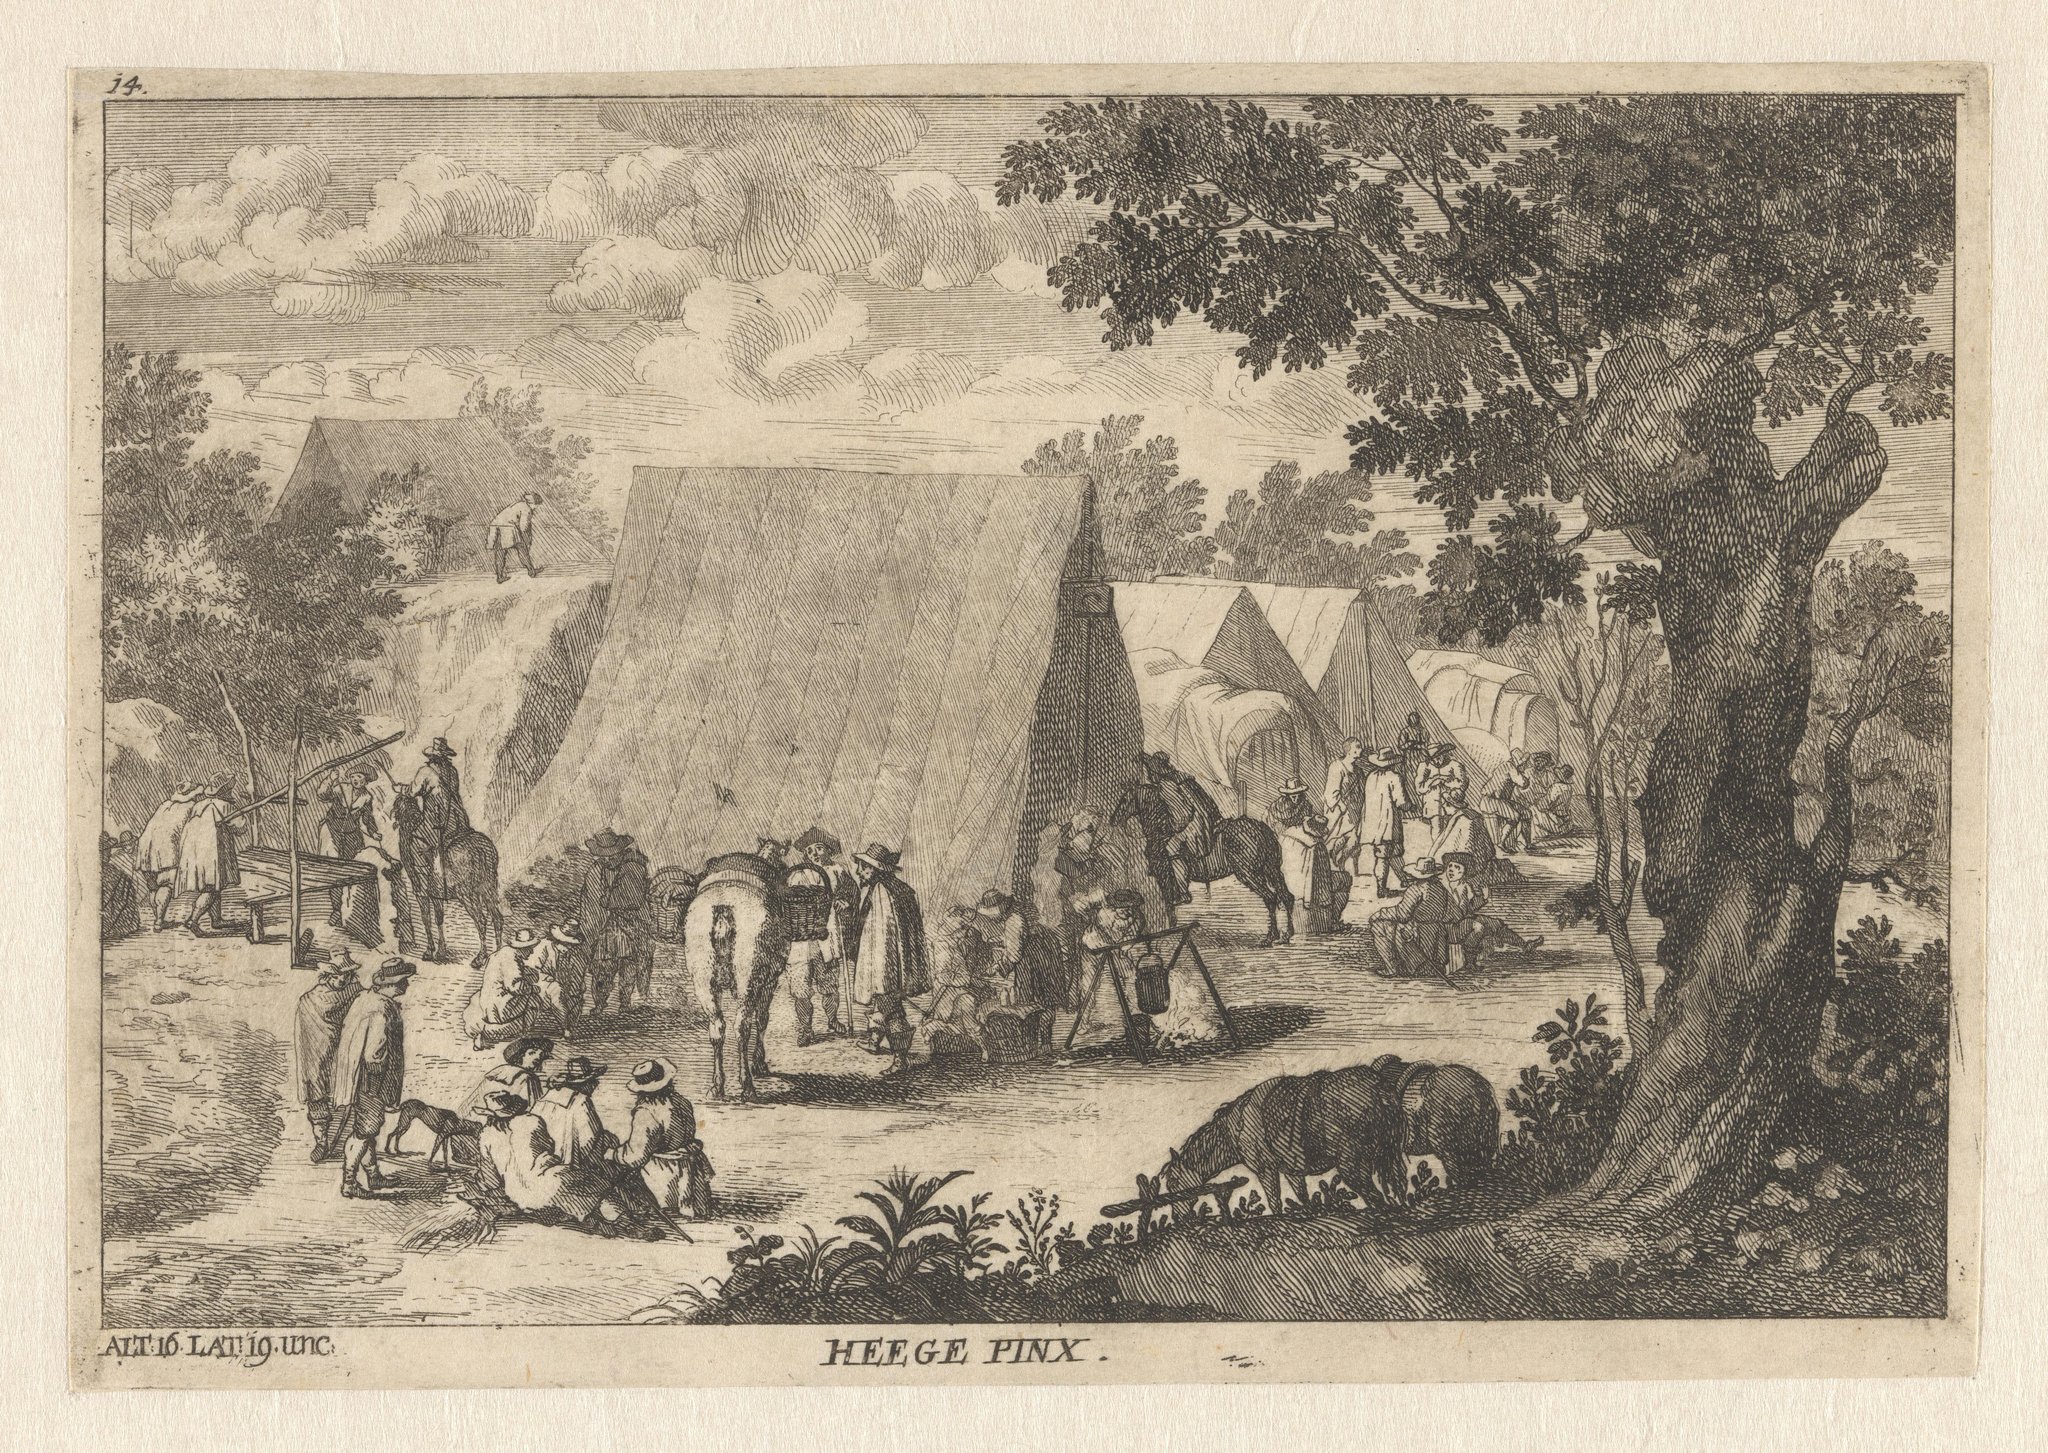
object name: print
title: Soldaten in een legerkamp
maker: anton joseph von prenner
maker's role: print maker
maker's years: 1683-1761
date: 1728-1733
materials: paper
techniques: etching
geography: vienna